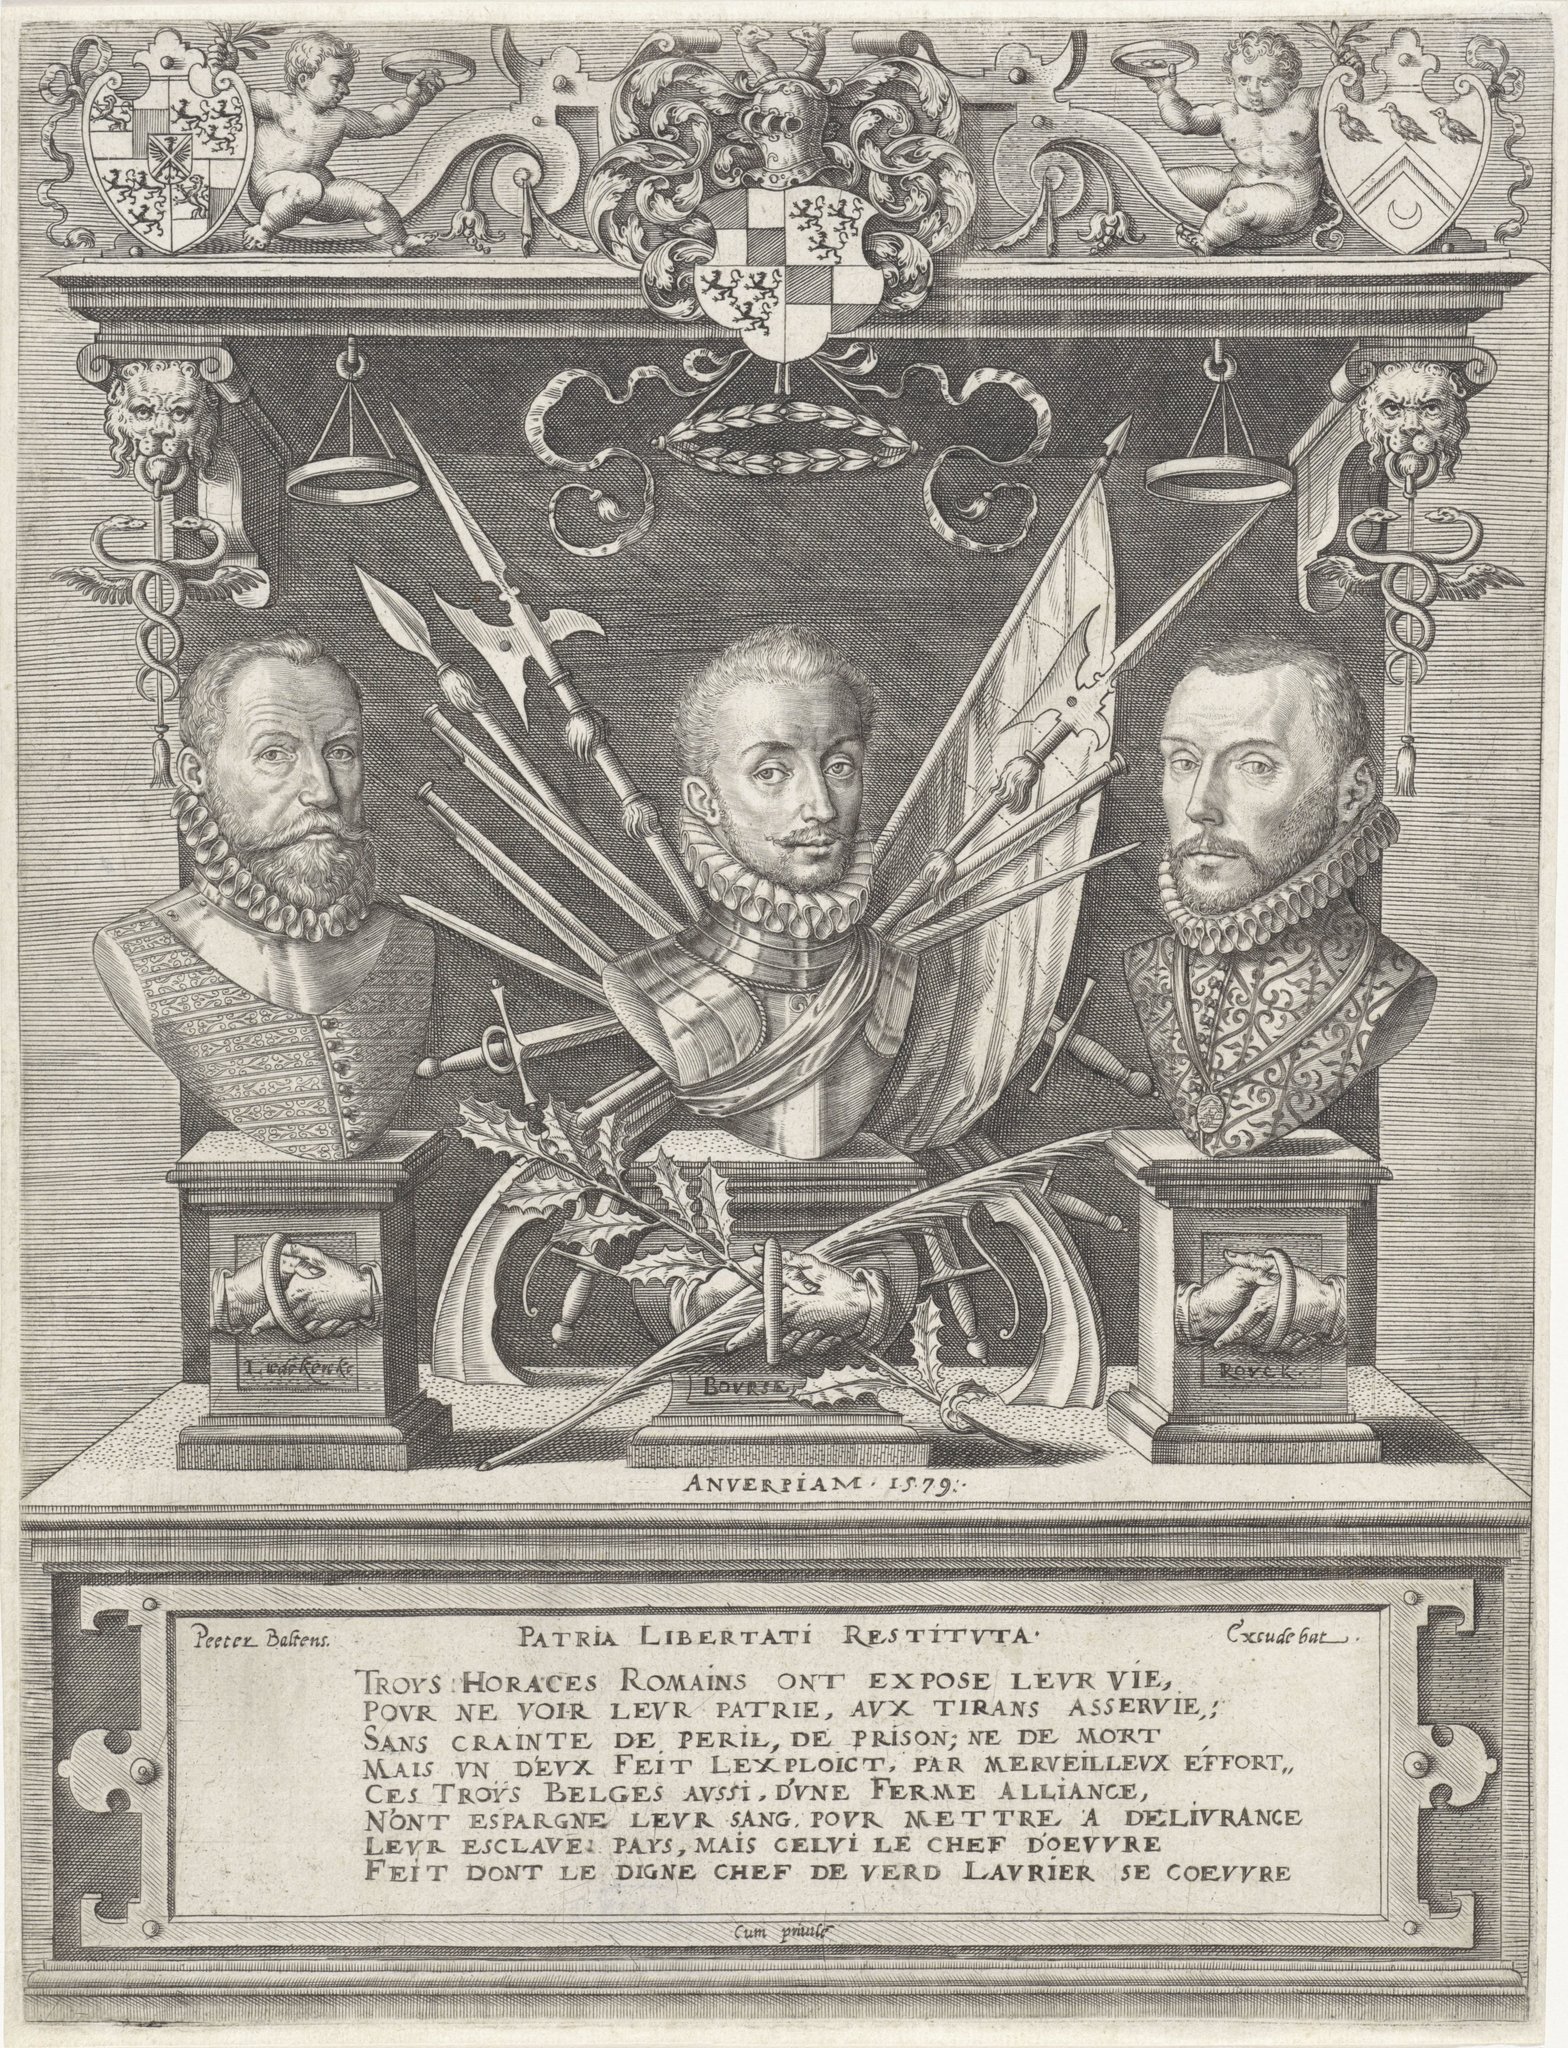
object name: propagandaprent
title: Titelprent met portretten van de helden Liedekercke, Bourse en Roeck, 1577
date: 1579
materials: paper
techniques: engraving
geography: antwerp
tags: frankness, loyalty; 'lealtà', 'realtà' (ripa) (+ symbolical representation of concept), armour, armorial bearing, heraldry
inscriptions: collector's mark: Lugt 2228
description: Titelprent met portretten van de helden Liedekercke, Bourse en Roeck, 1577. Voetstuk met borstbeelden van de drie mannen met diverse symbolen van hun samenwerking en trouw. Bovenaan hun wapens, onderaan een cartouche met een vers van acht regels in het Frans.